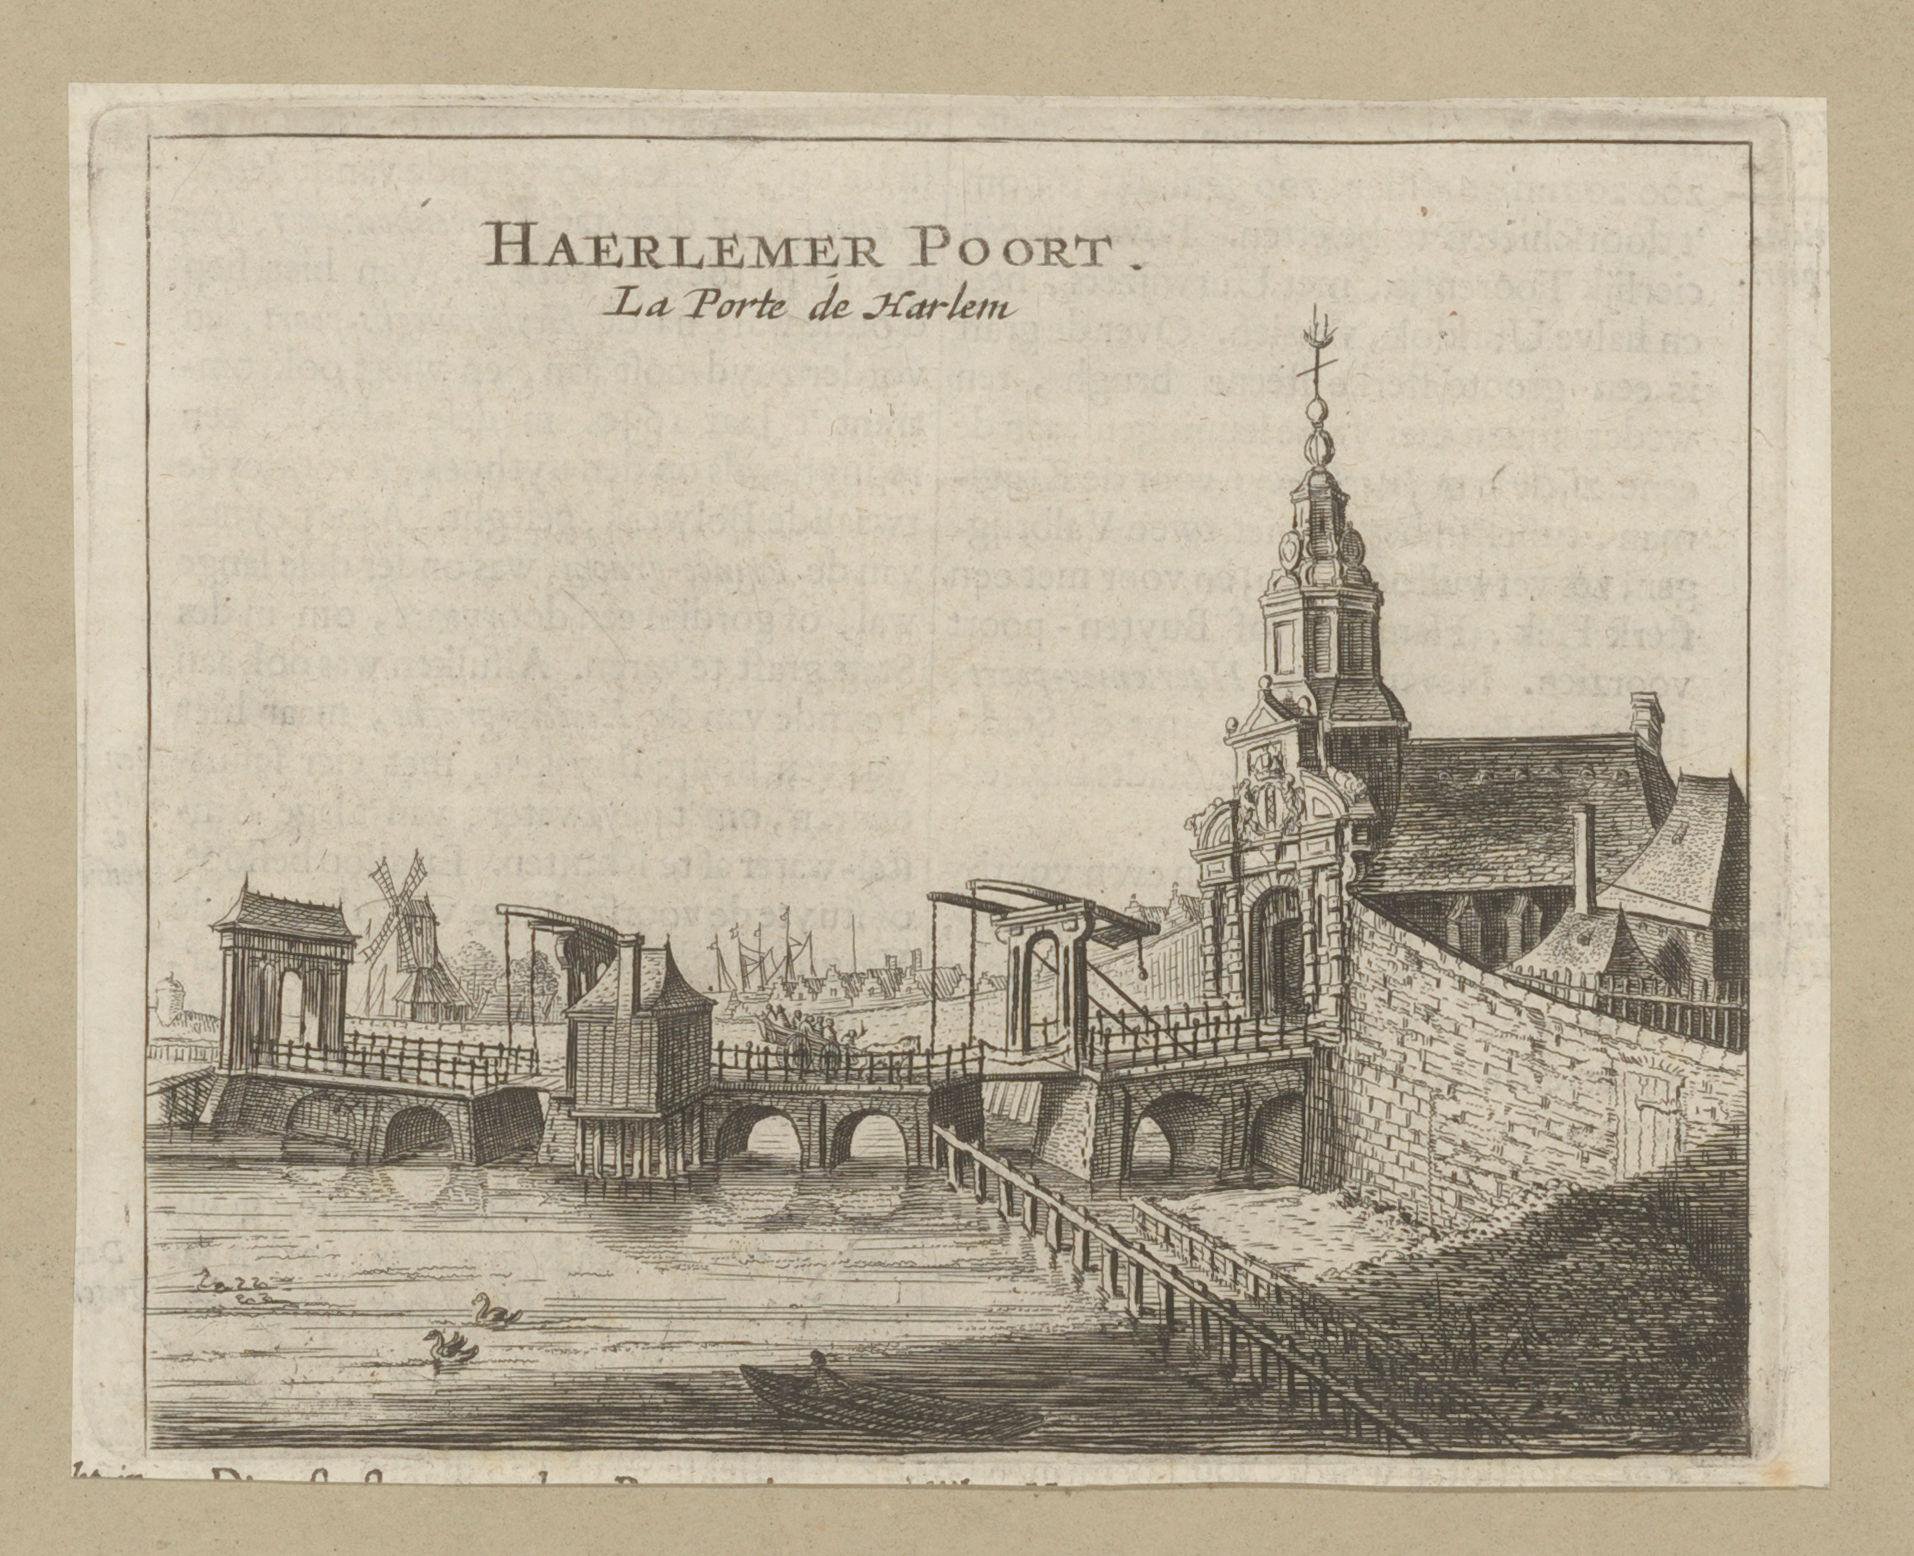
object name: print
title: Gezicht op de Haarlemmerpoort te Amsterdam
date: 1665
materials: paper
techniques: engraving, etching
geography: amsterdam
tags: rowing-boat, canoe, etc., bridge in city across river, canal, etc., city-gate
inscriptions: collector's mark: Lugt 1641b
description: Huidige tweede bekende staat (met toevoeging Franse titel) ook gebruikt in: Domselaer, Tobias en Isaac Commelin. Beschryvinge van Amsterdam : haar eerste oorspronk uyt den huyze der heeren van Aemstel en Aemstellant (…). 6 dln. Amsterdam: Marcus Willemsz van Doornick, 1665. Eerste staat van prent ook gebruikt in: Fockens, Melchior. Beschrijving Der wijdt-vermaarde Koop-stadt Amstelredam, Van haar eerste beginselen, zedert den Jare 1203. oude Voorrechten, verscheyde Vergrootingenoude Voor-rechten, en verscheyde Vergrootingen (…). 3de druk. Amsterdam: Marcus Willemsz. Doornick, 1664. En in: Zesen, Philipp von. Beschrybung der Weidtberuhmde Kauf-Stadt Amstelredam / Beschreibung der Stadt Amsterdam darinnen von derselben ersten ursprunge bis auf gegenwartigen zustand (…). Amsterdam: Marcus Willemsz. Doornick, 1664. Derde bekende staat (rechtsboven genummerd: 64) ook gebruikt in verschillende latere zeventiende- en achttiende-eeuwse publicaties.